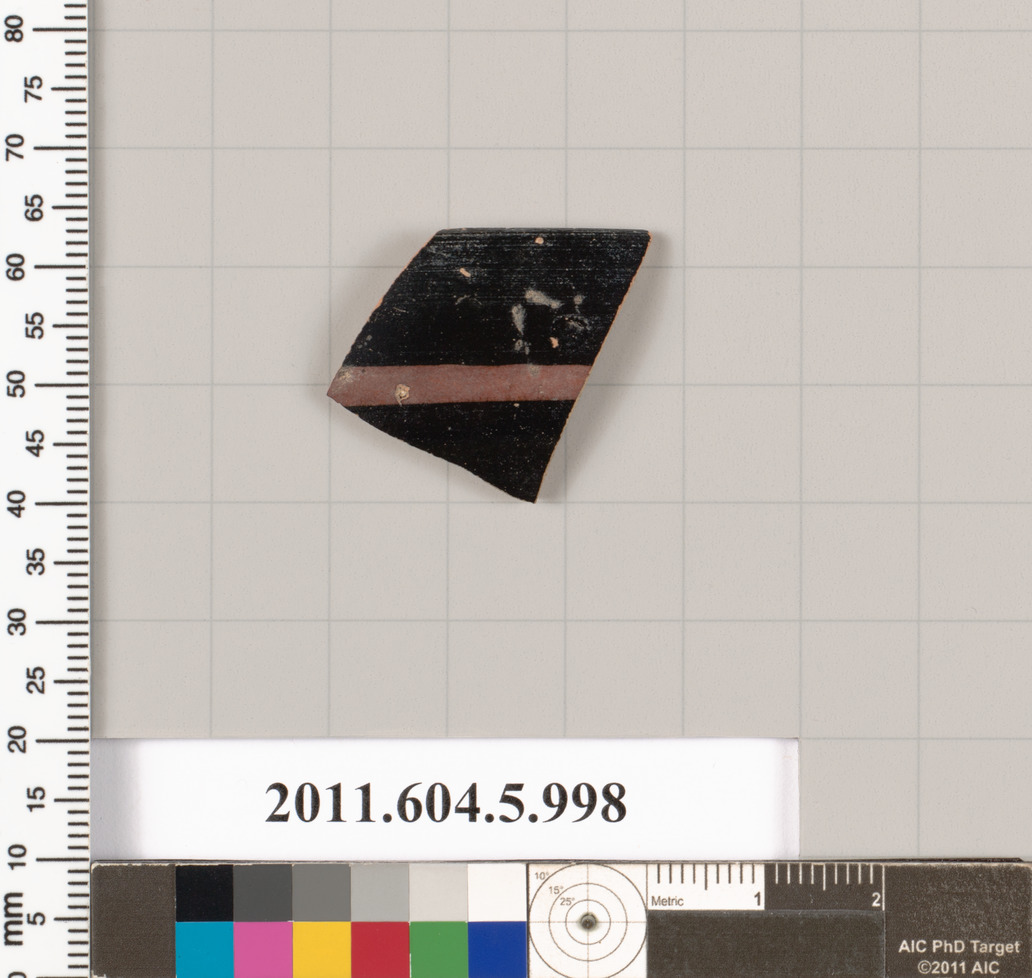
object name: kylix fragment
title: Terracotta rim fragment of a kylix (drinking cup)?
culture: greek, attic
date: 600-401 BCE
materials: terracotta